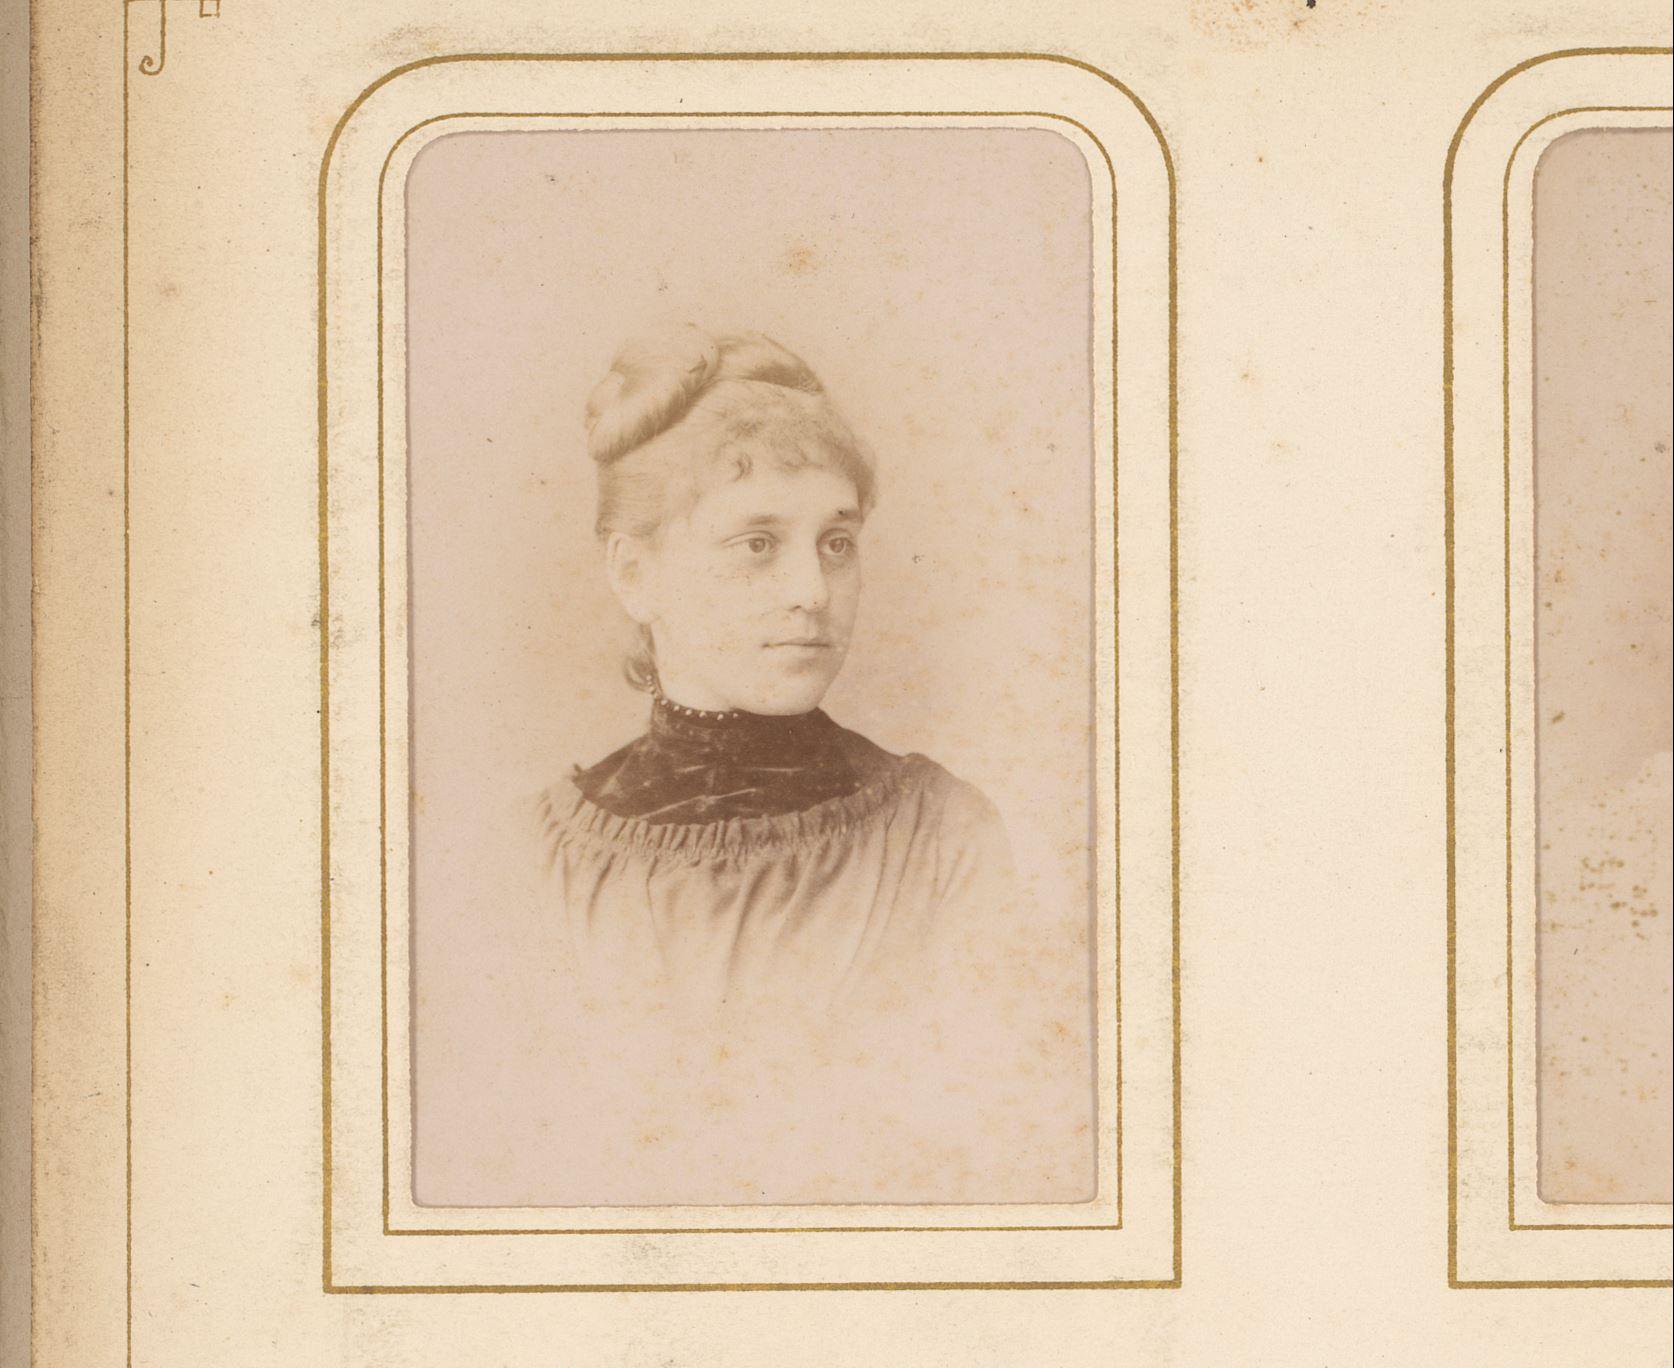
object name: photograph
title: Portret van een jonge vrouw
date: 1876-1879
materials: cardboard, photographic support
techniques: albumen print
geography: brussels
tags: adolescent, young woman, maiden, historical persons - bb - woman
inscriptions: inscription: ‘Günther/ Bruxelles/ RUE NEUVE 23.’